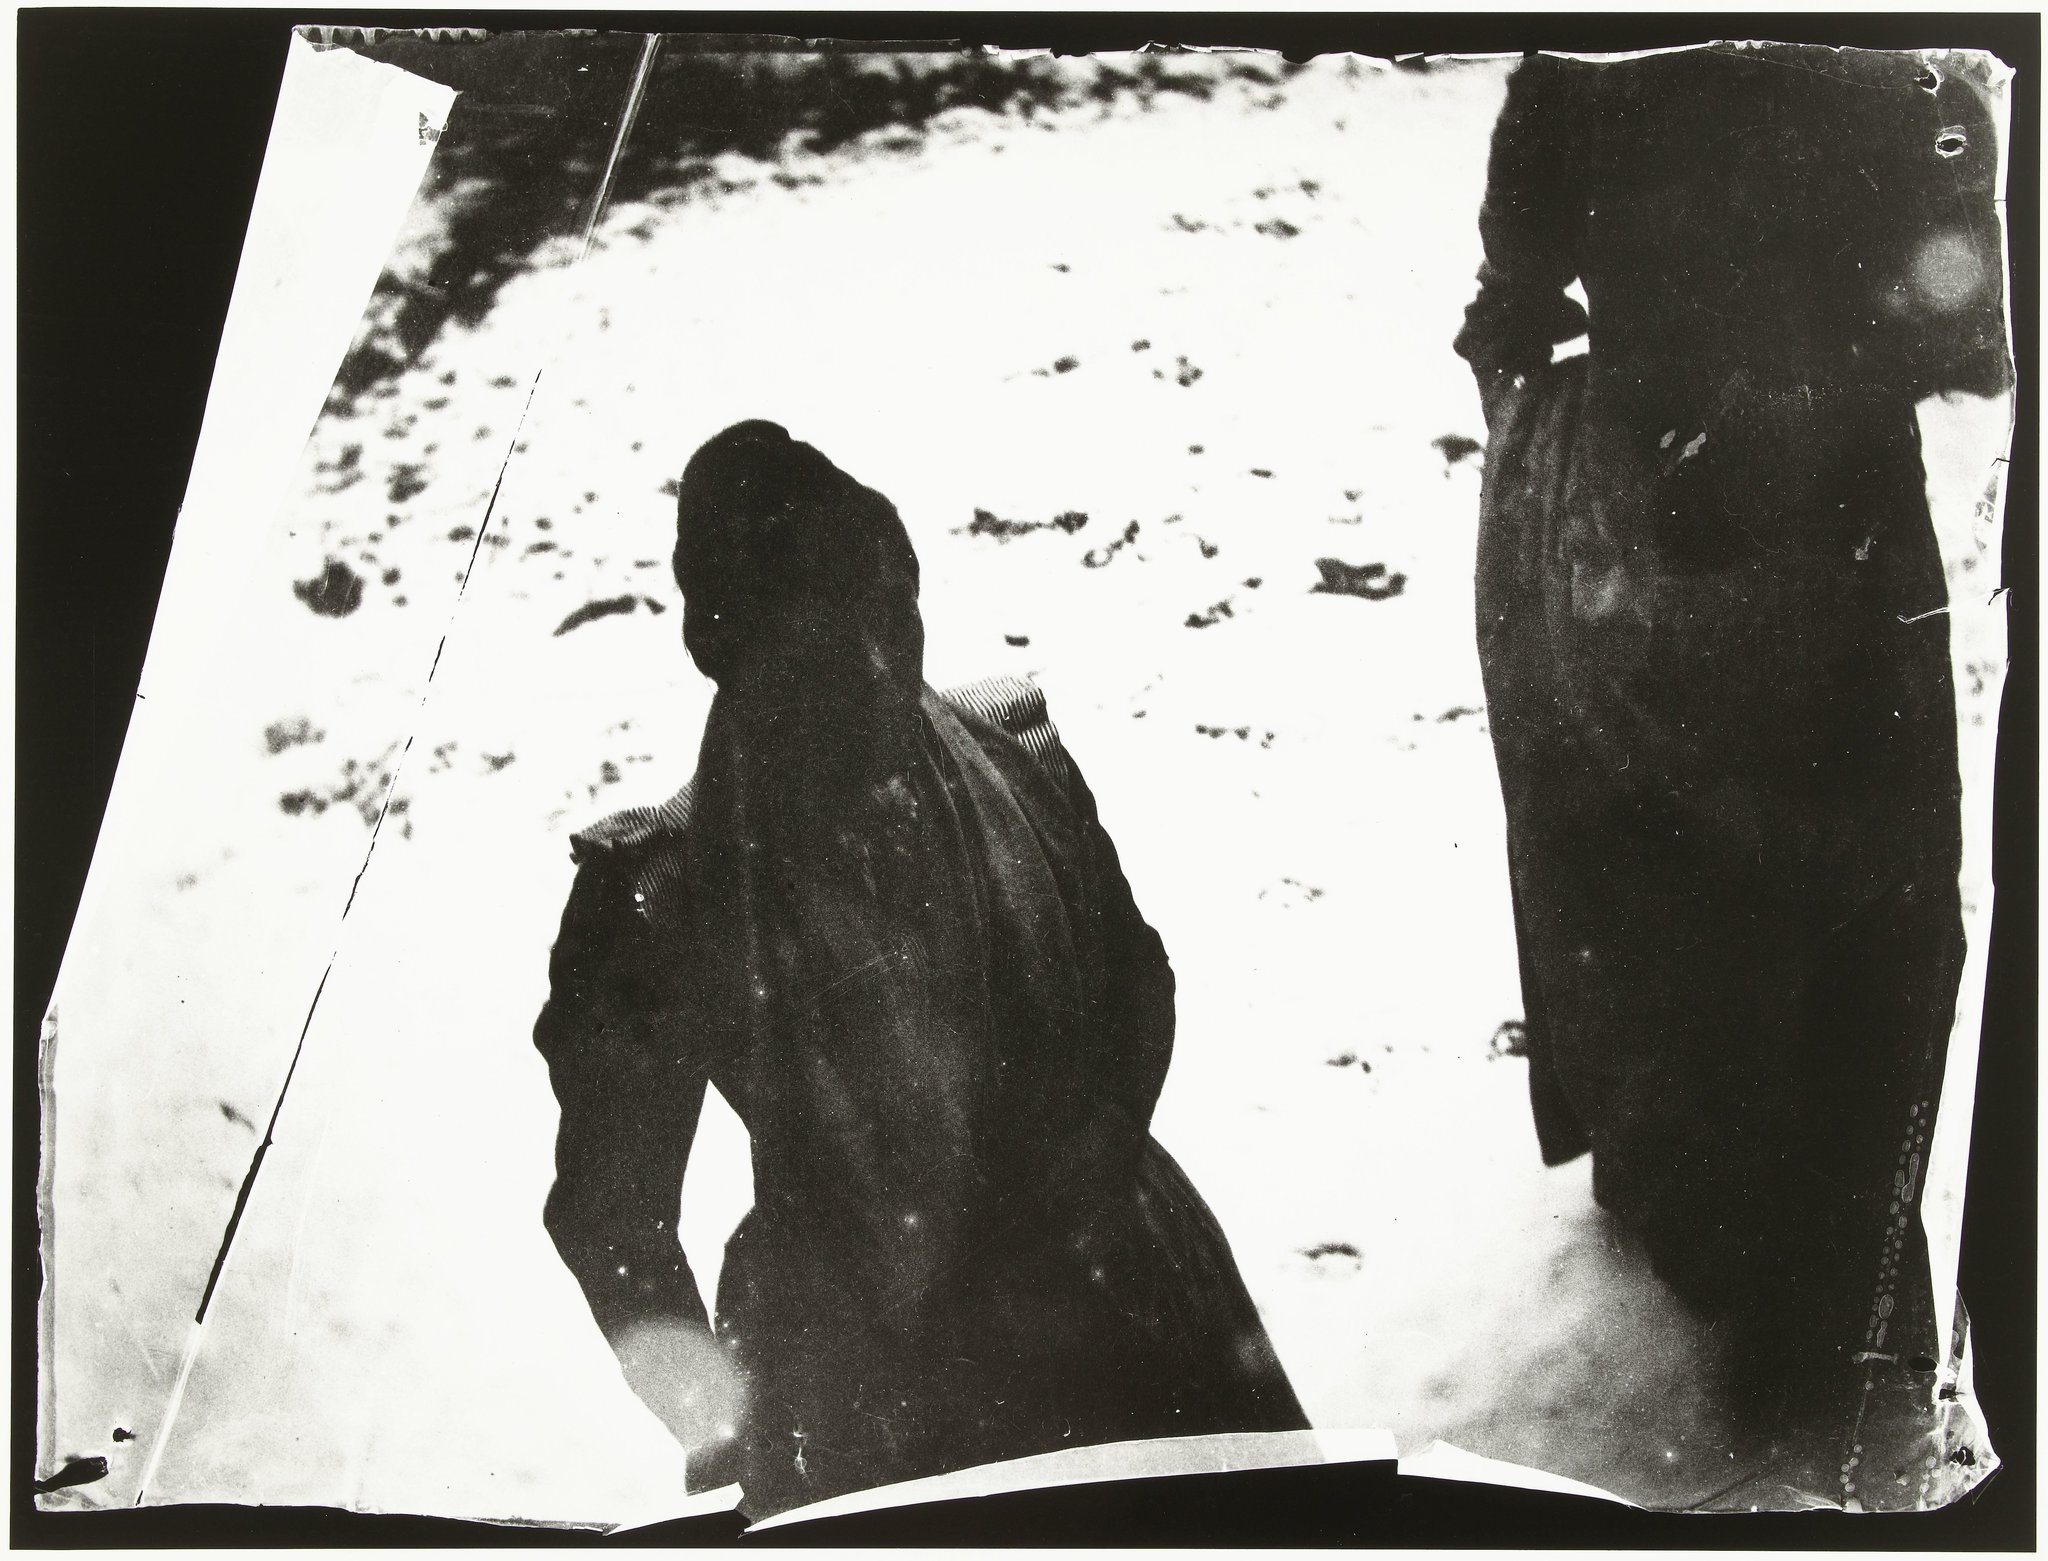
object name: photograph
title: Twee vrouwen in de sneeuw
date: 1890-1910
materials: paper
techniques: gelatin silver print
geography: amsterdam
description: De foto is afgedrukt van een gevouwen en beschadigd negatief. Moderne afdruk van negatief BR 83 (collectie RKD).